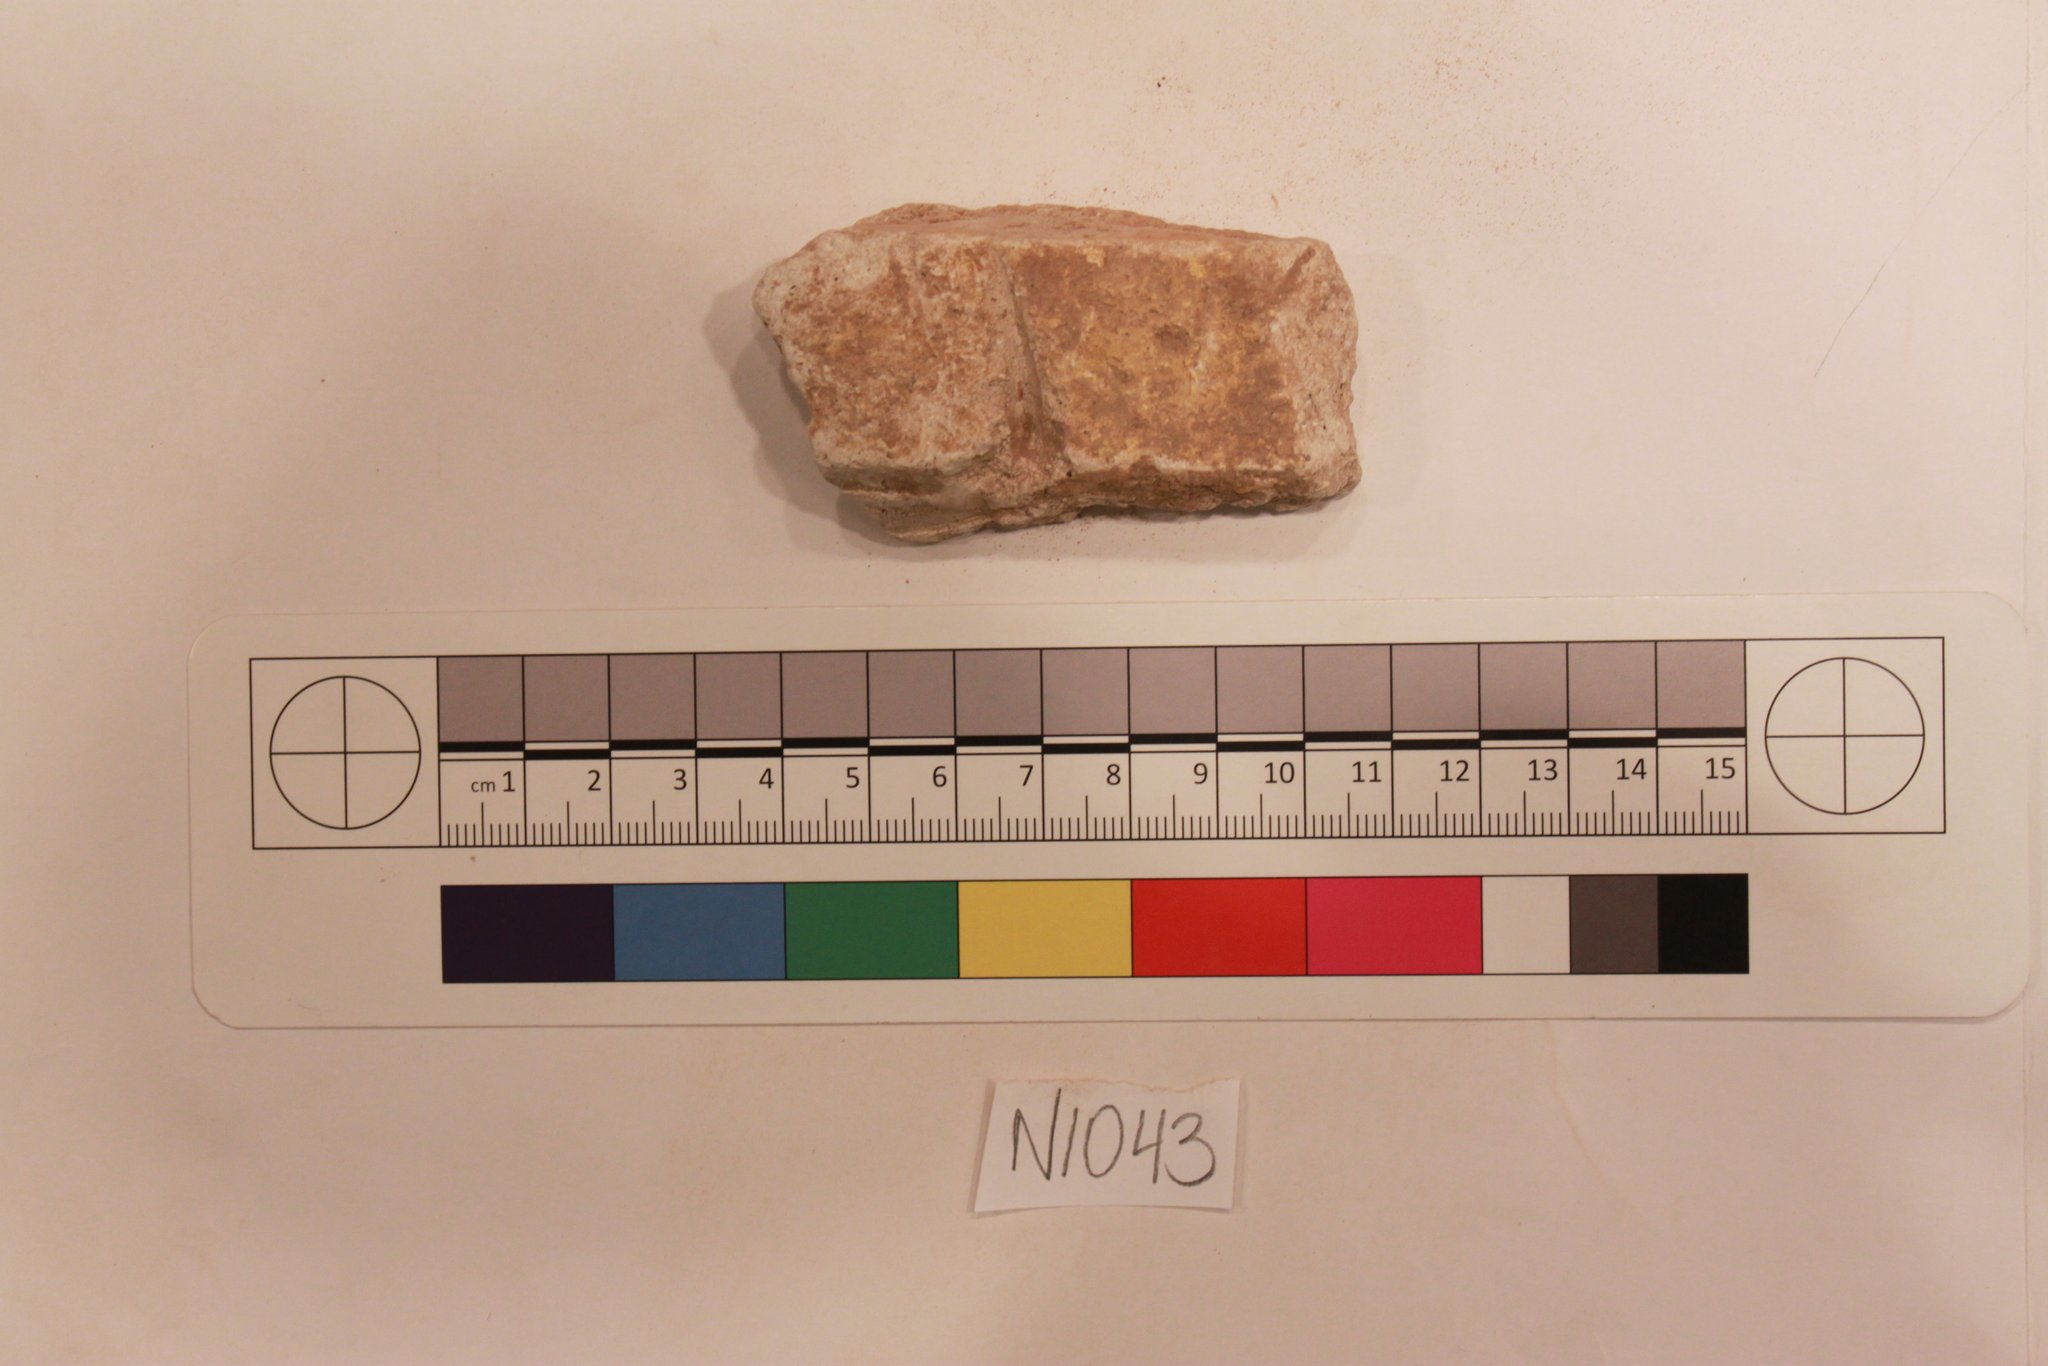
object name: fragment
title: Stucco Fragment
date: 701-1200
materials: plaster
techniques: carving, painting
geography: iran